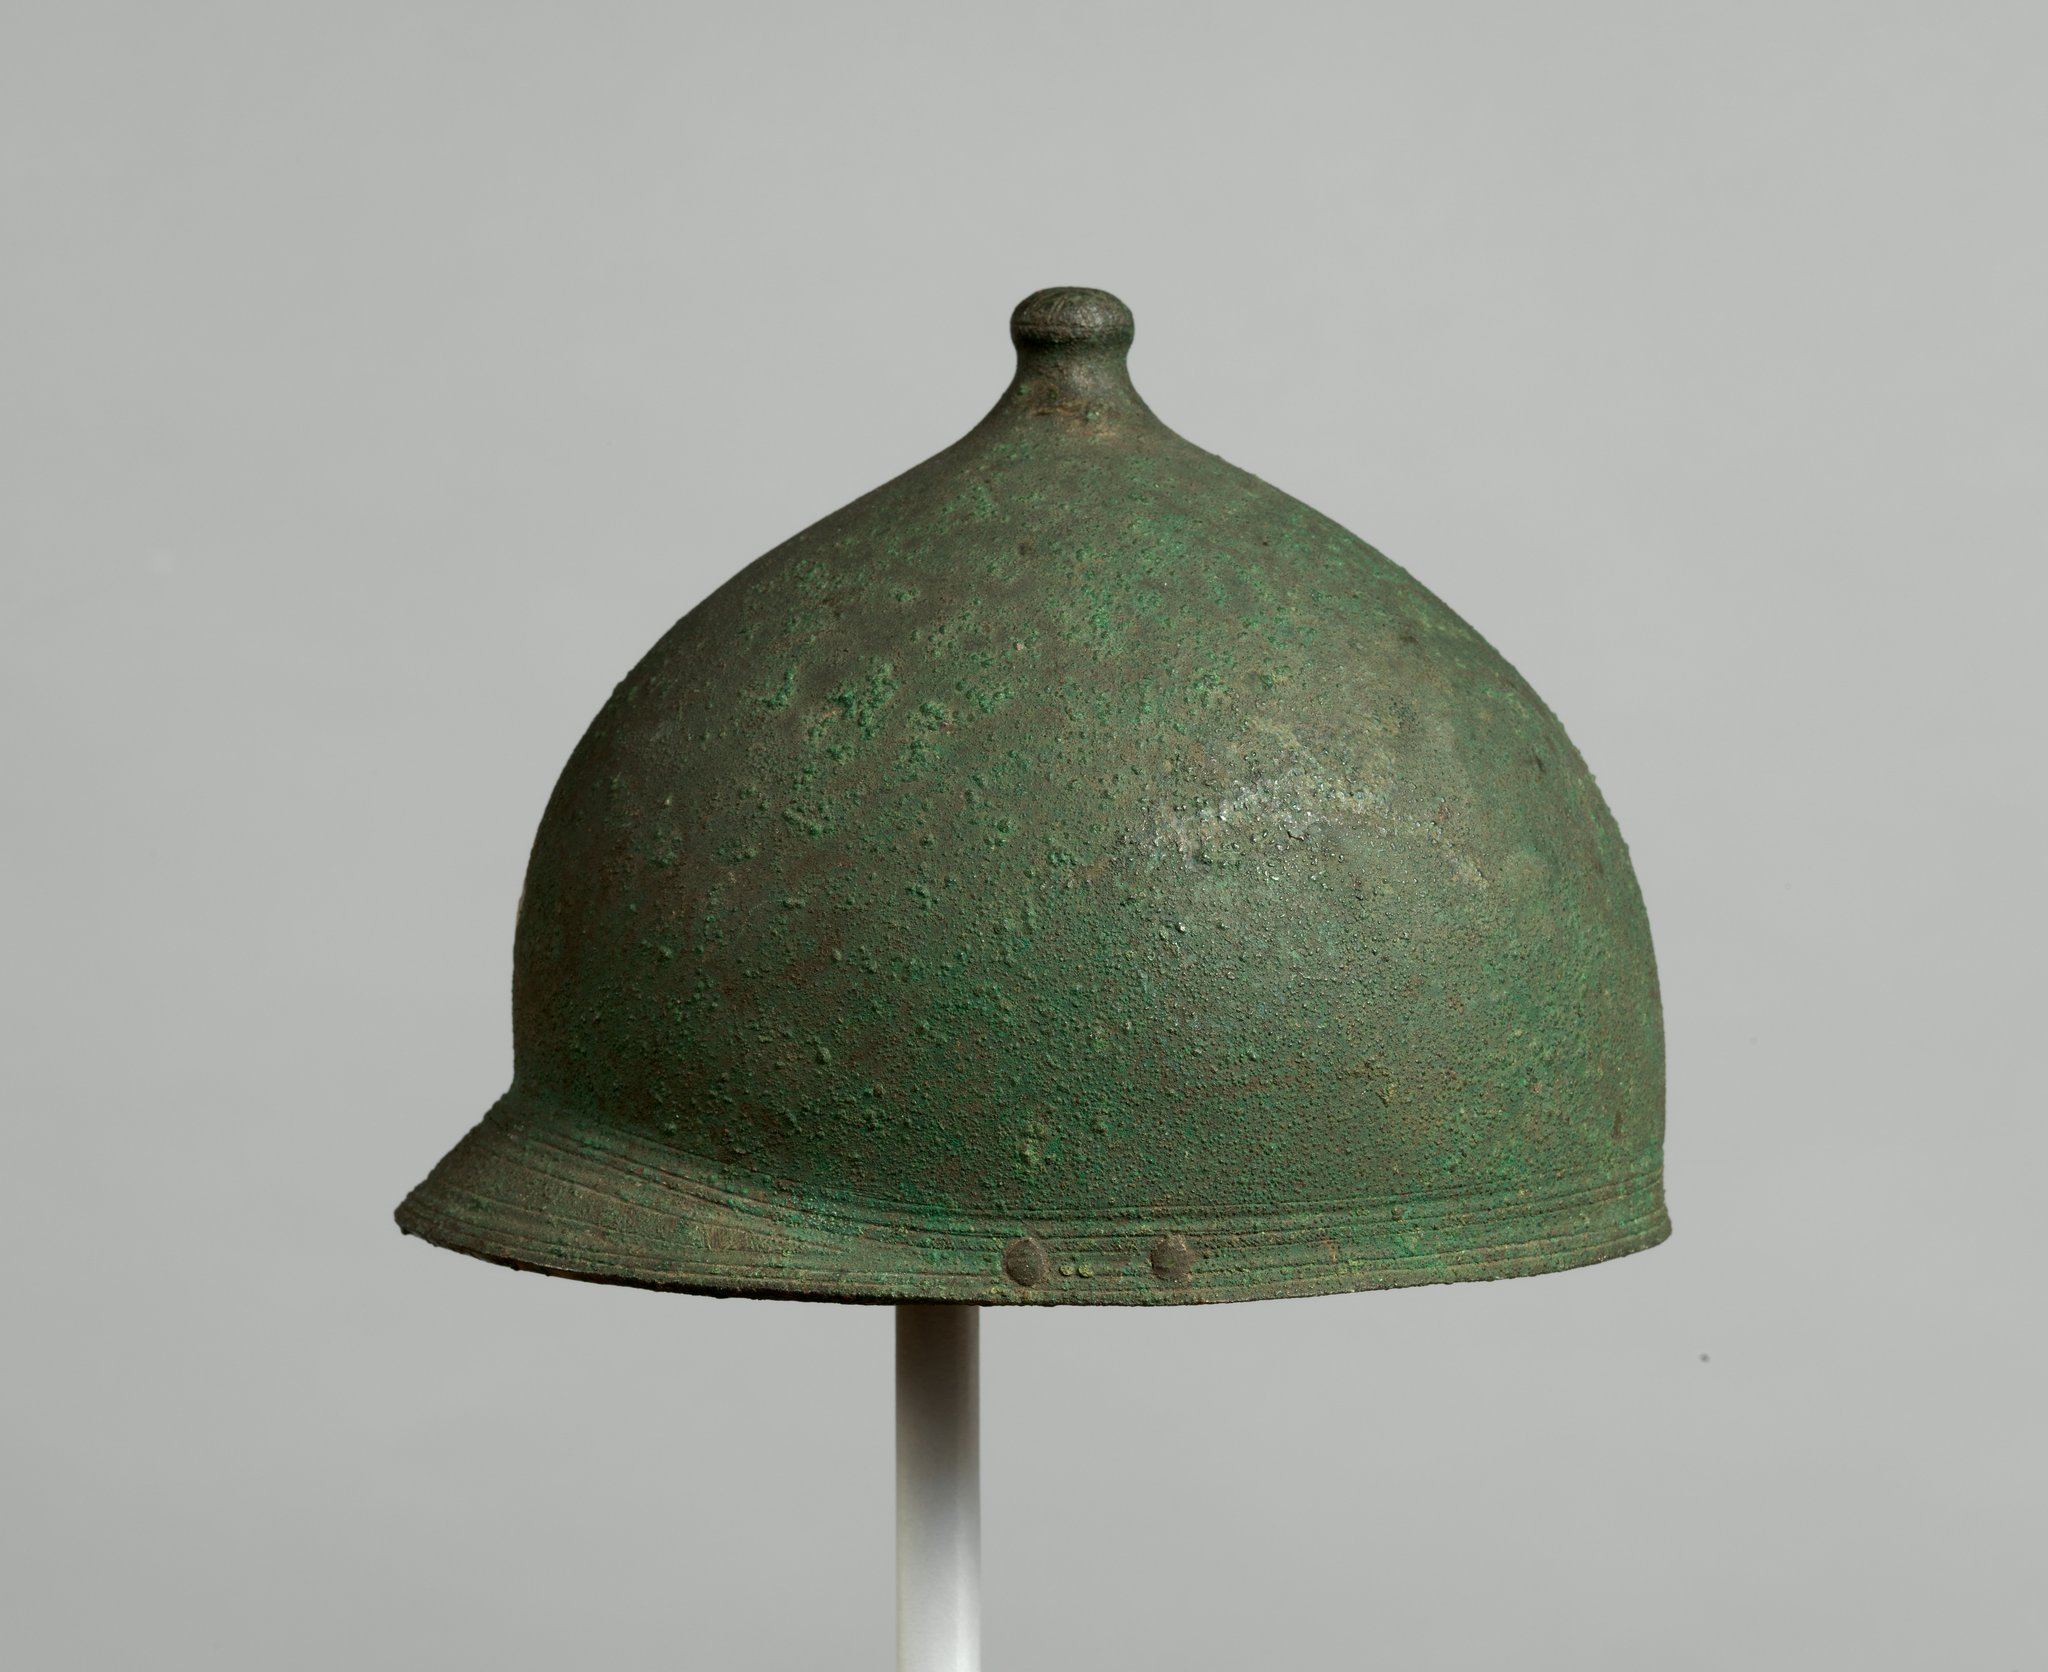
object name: helmet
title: Helmet of the Montefortino Type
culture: etruscan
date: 233-367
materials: bronze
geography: italy